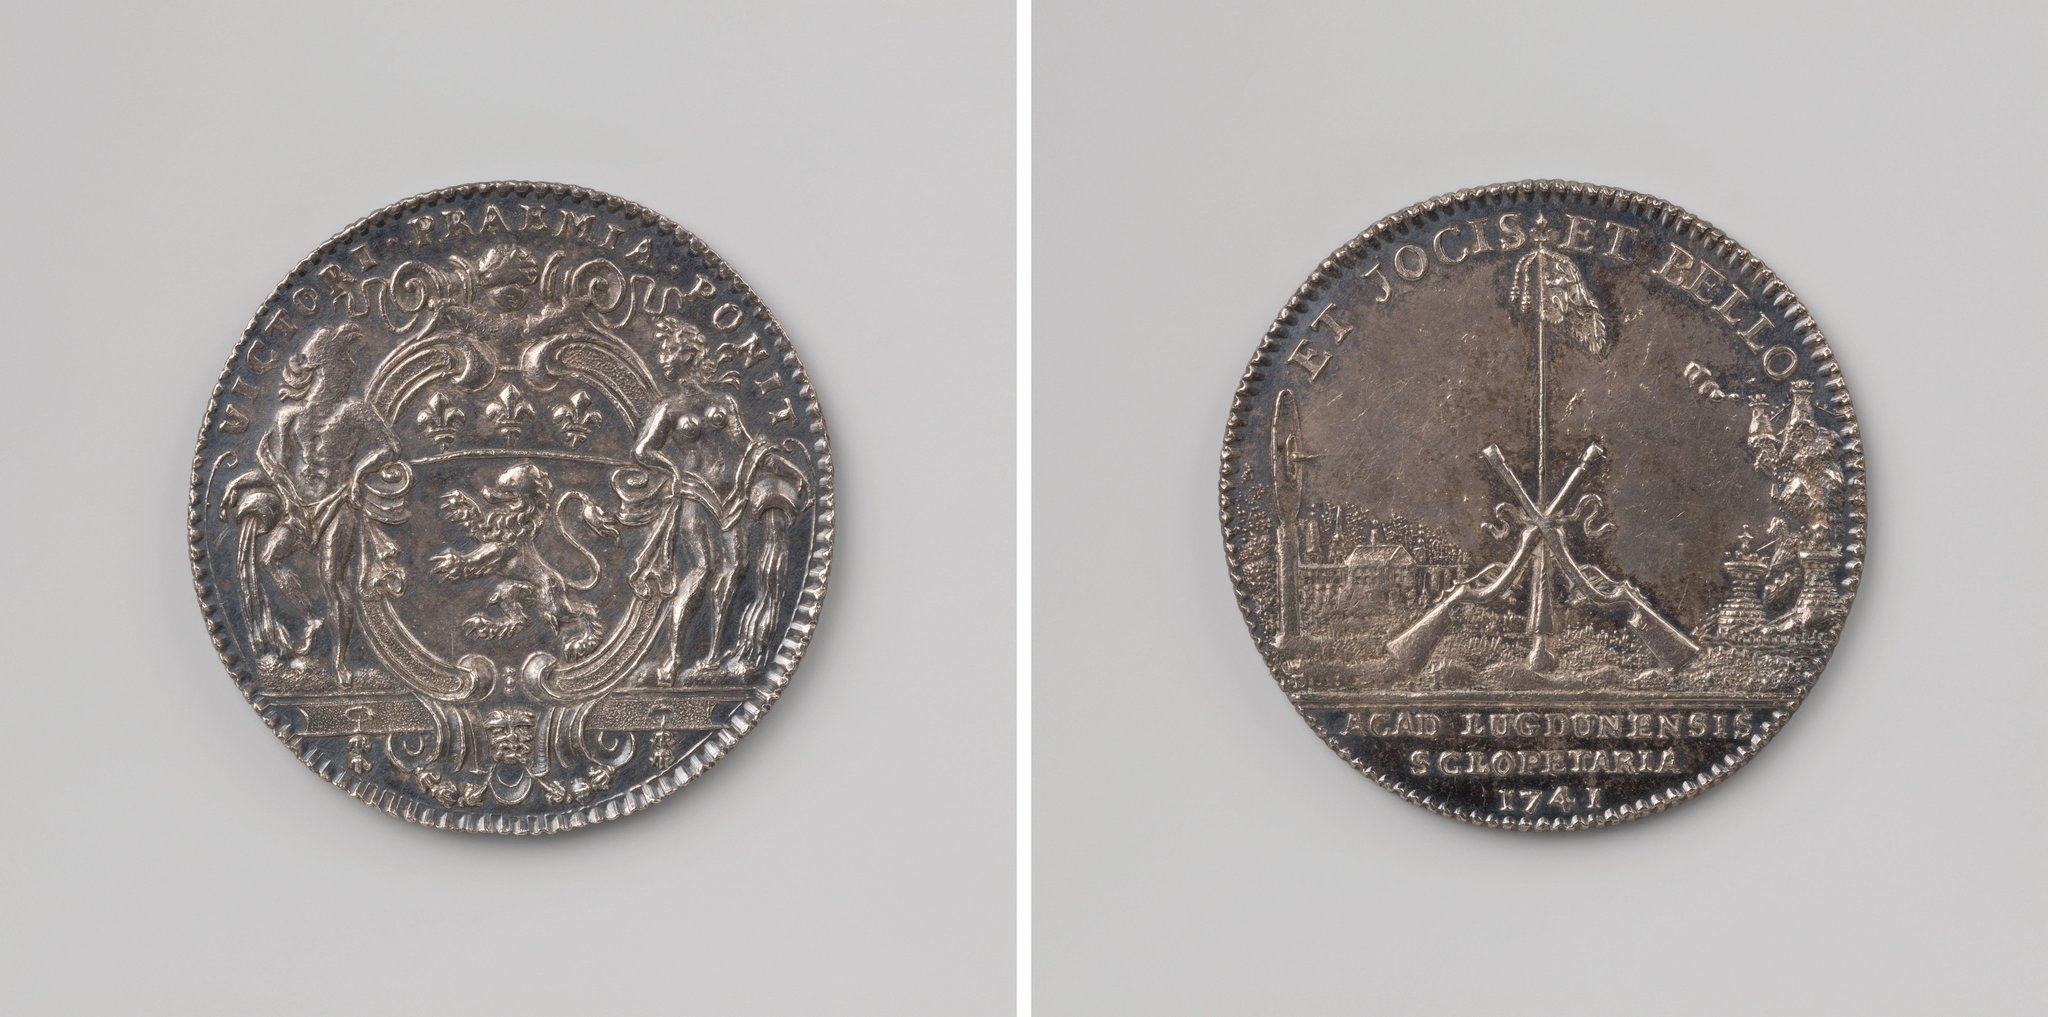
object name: marksman medal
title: Schuttersfeest van de universiteit van Leiden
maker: Anonymous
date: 1741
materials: silver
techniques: striking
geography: leiden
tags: leiden